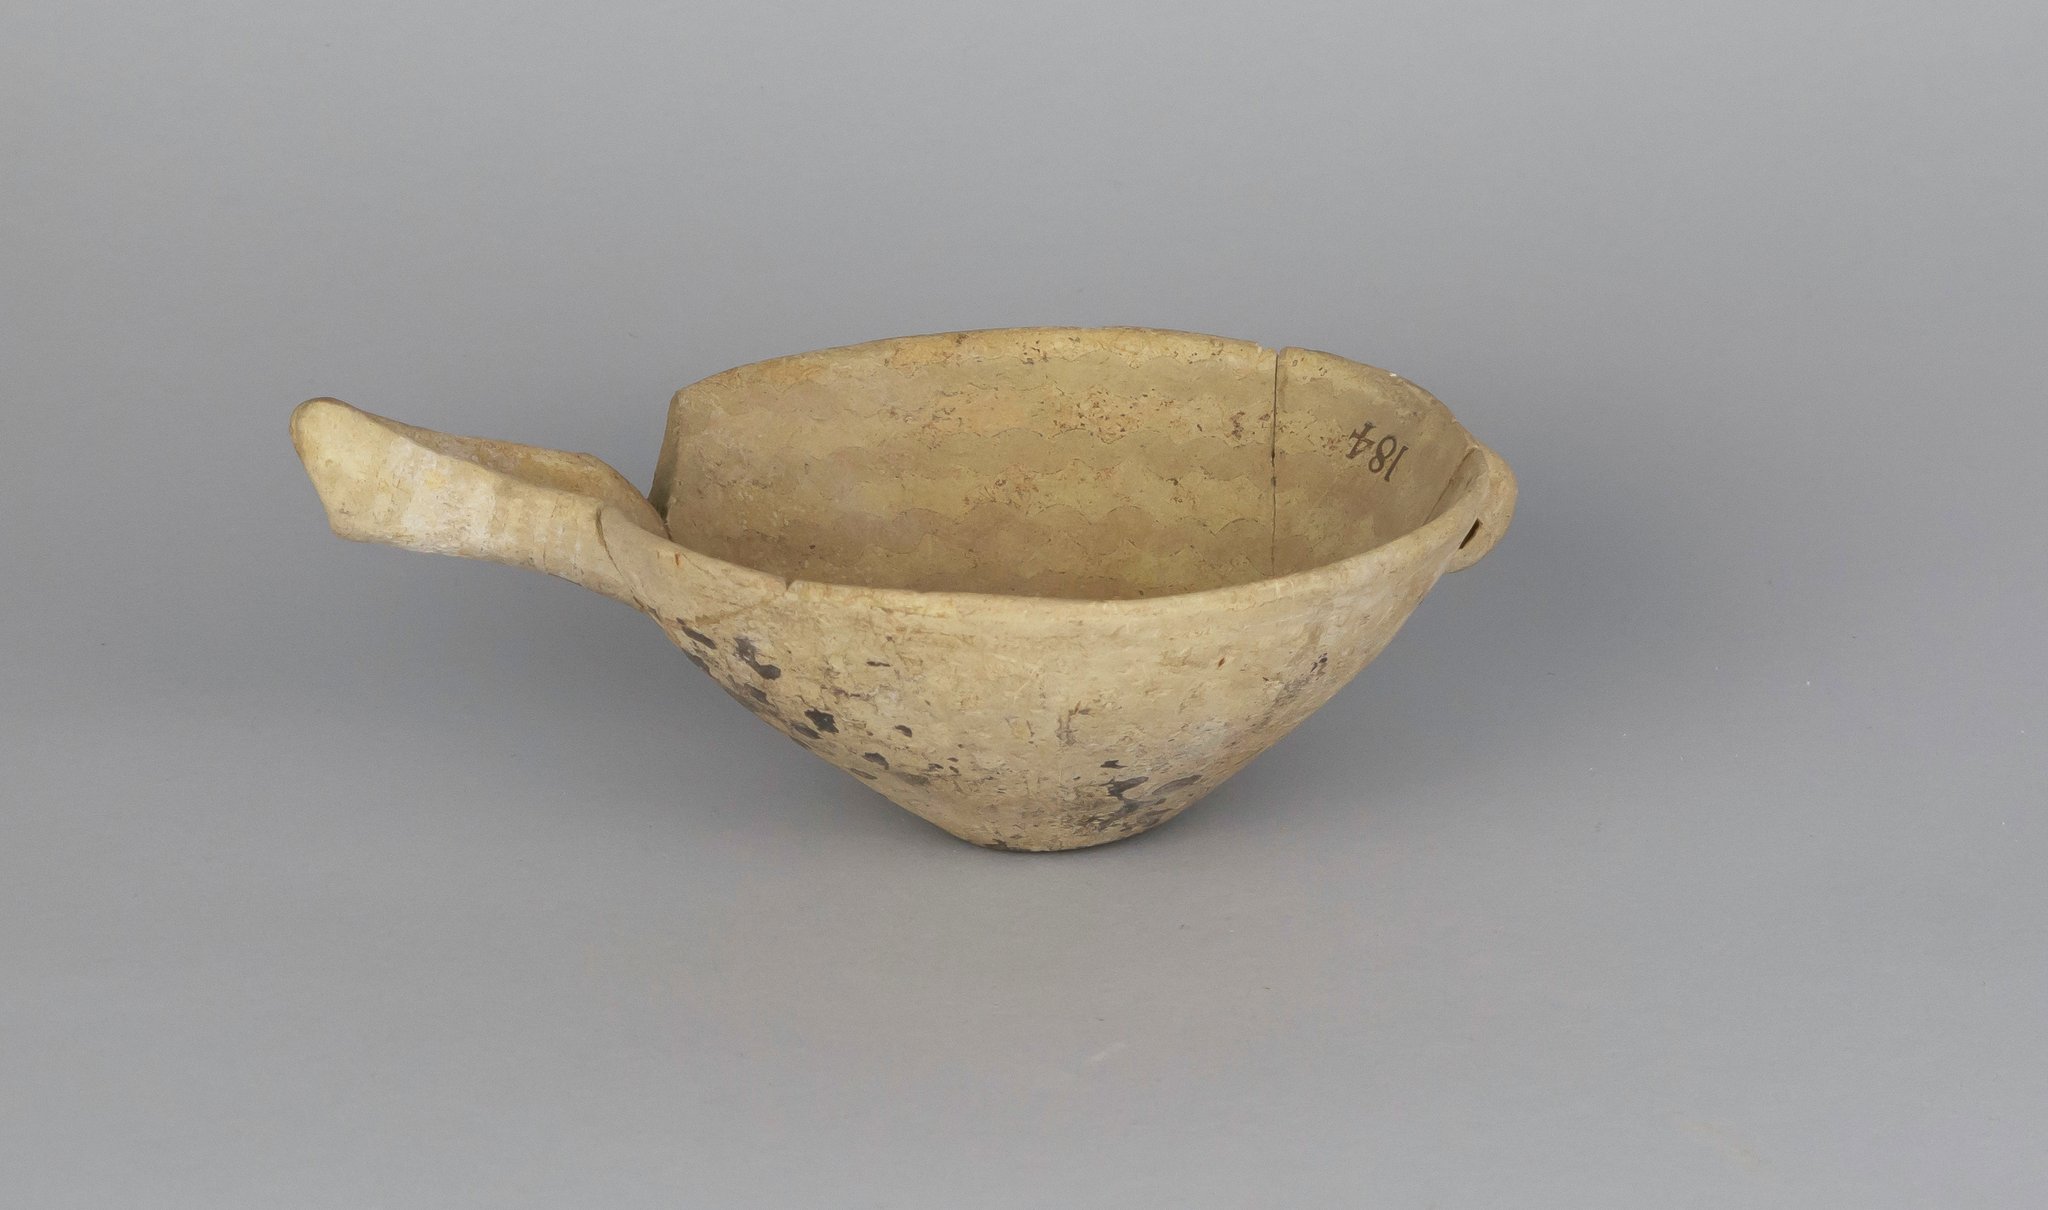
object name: bowl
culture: cypriot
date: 2000-1600 BCE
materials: terracotta